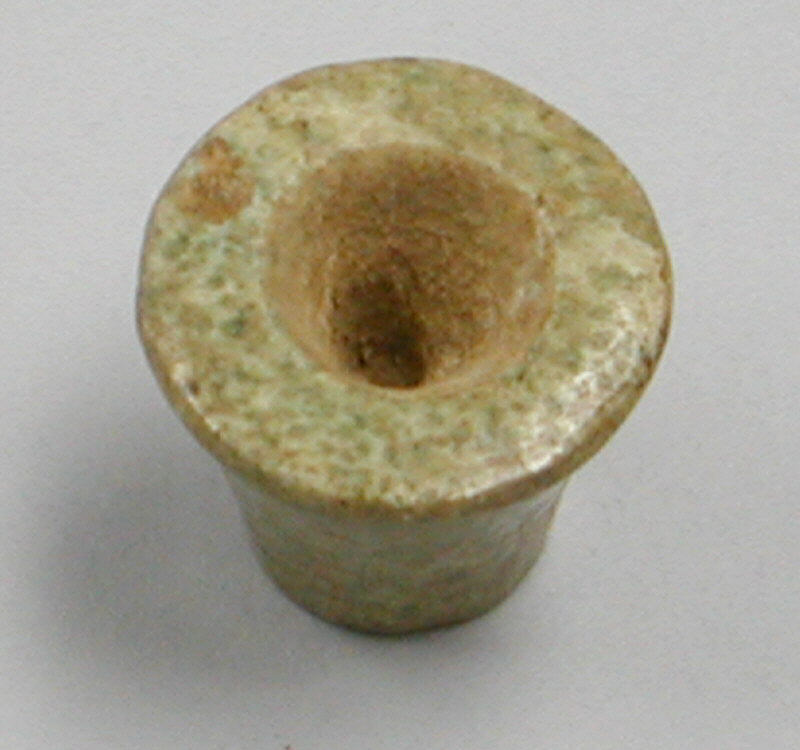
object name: earflare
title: Stone Earflare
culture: mexican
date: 1501-1600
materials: stone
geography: mexico